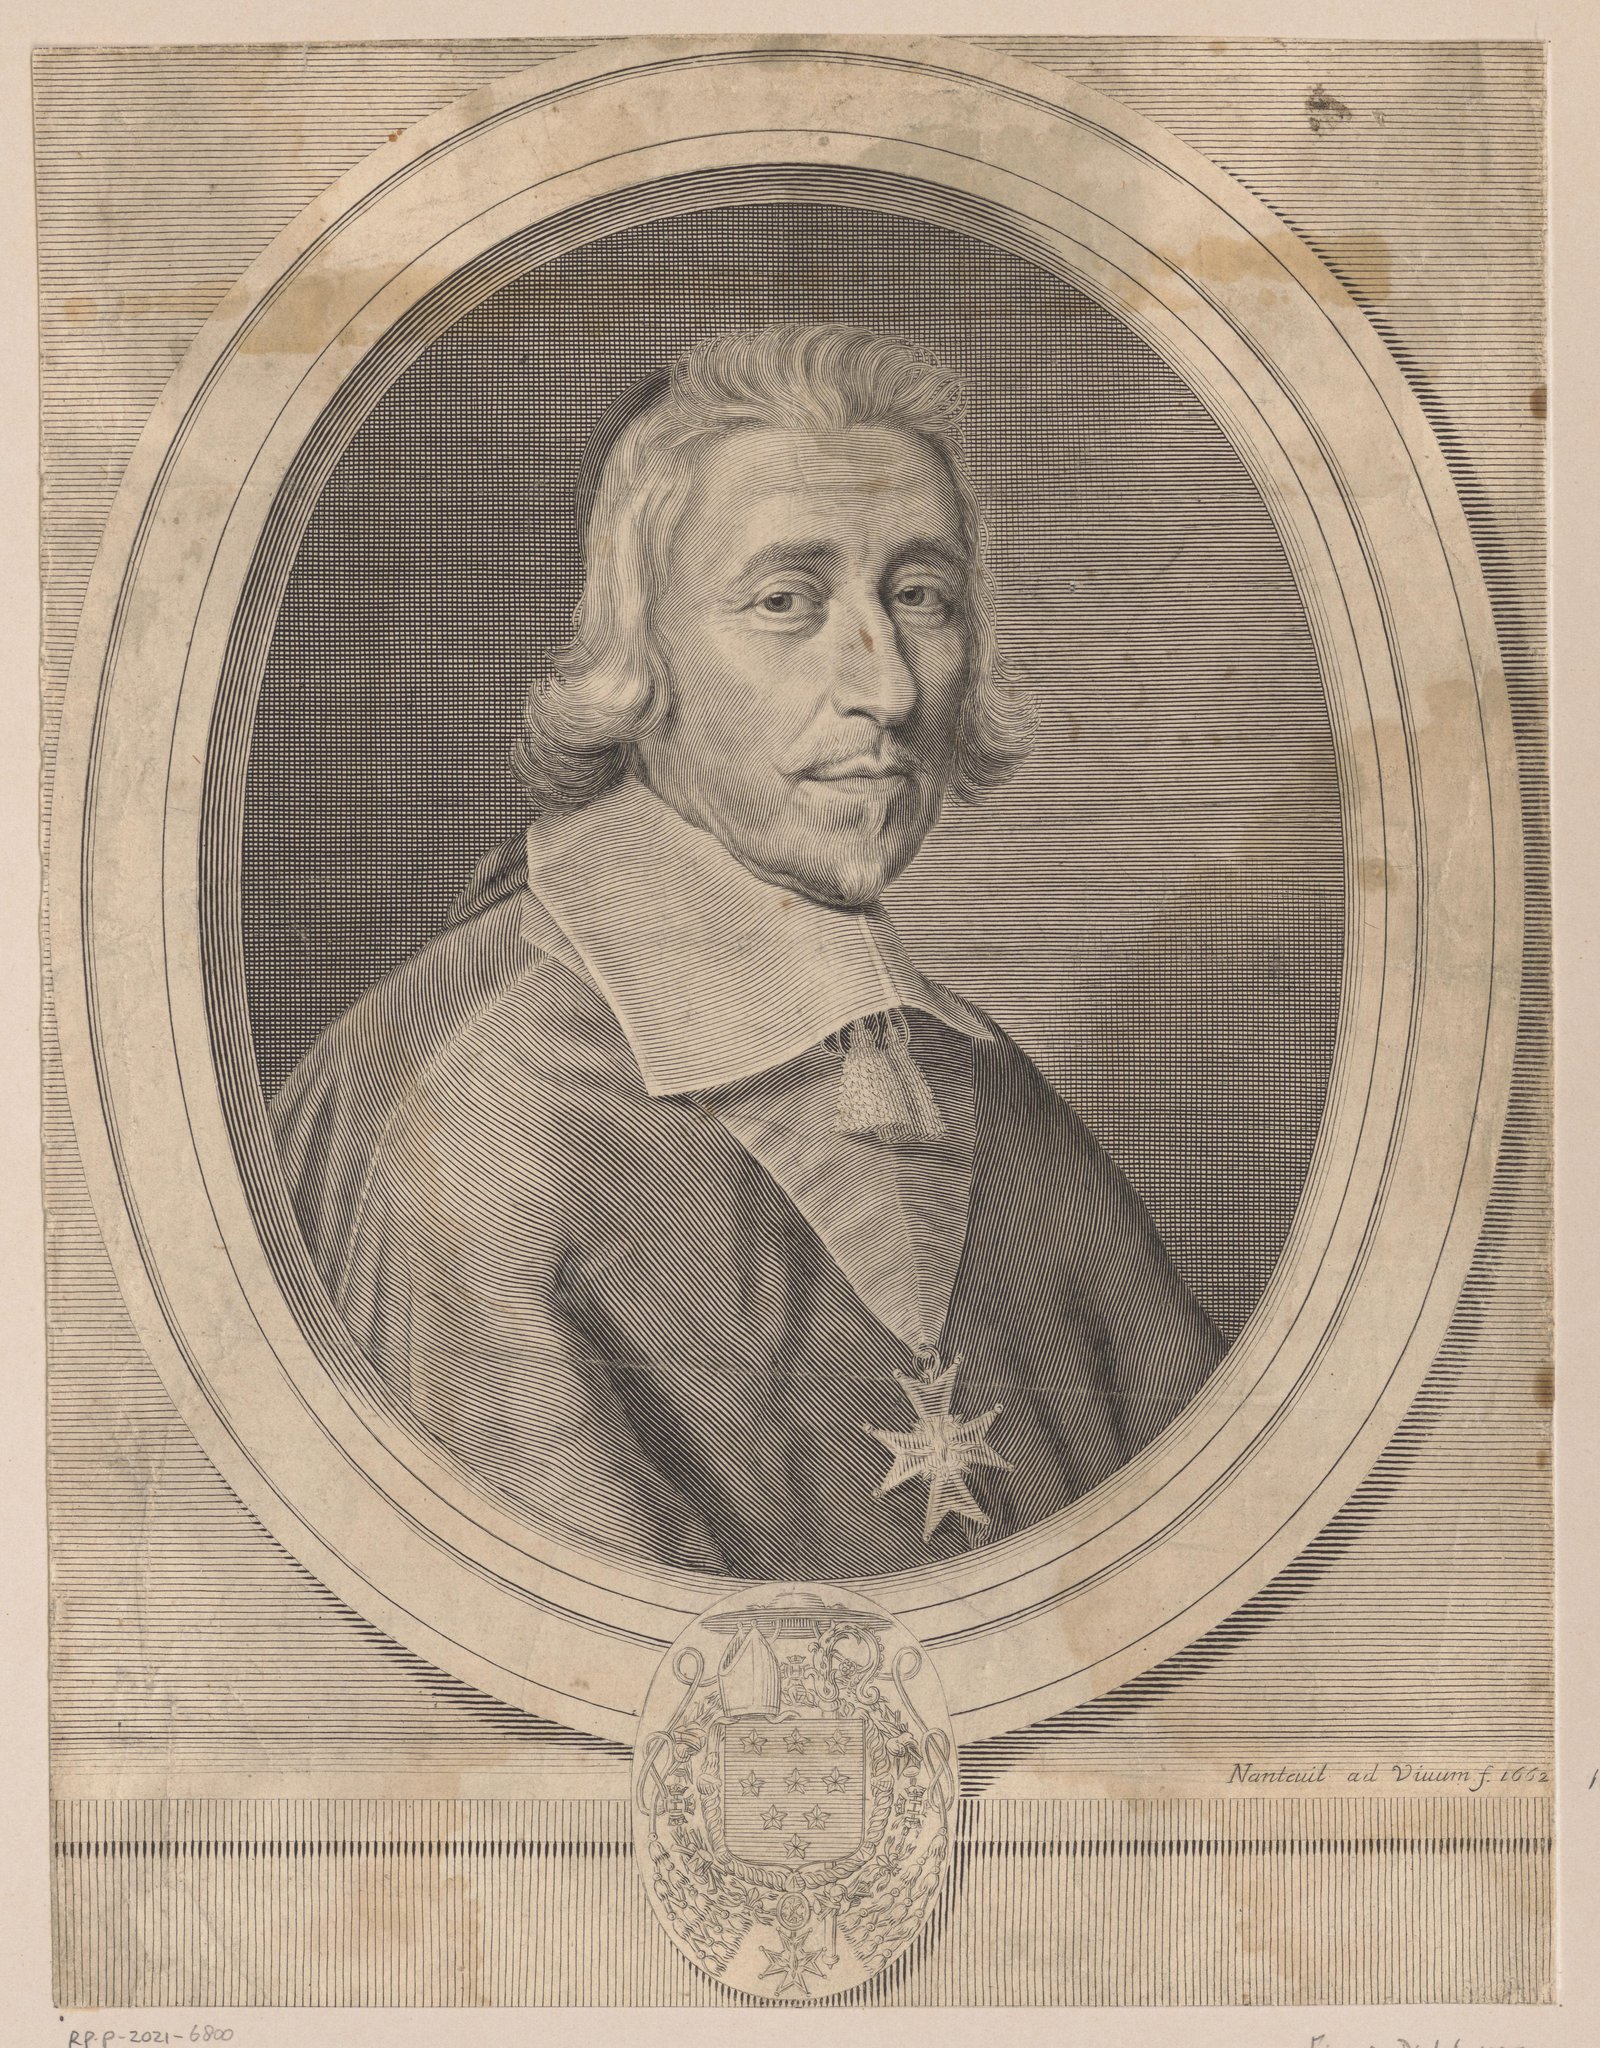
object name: print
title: Portret van Hardouin de Péréfixe de Beaumont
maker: robert nanteuil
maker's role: print maker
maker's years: 1623-1678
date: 1662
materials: paper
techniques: engraving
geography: france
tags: paris, adult man, historical persons, armorial bearing, heraldry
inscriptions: inscription: ‘Rta. [Registrata] Ehrn-[?] tra In/ oben N[o] 219’, collector's mark: Lugt 1337